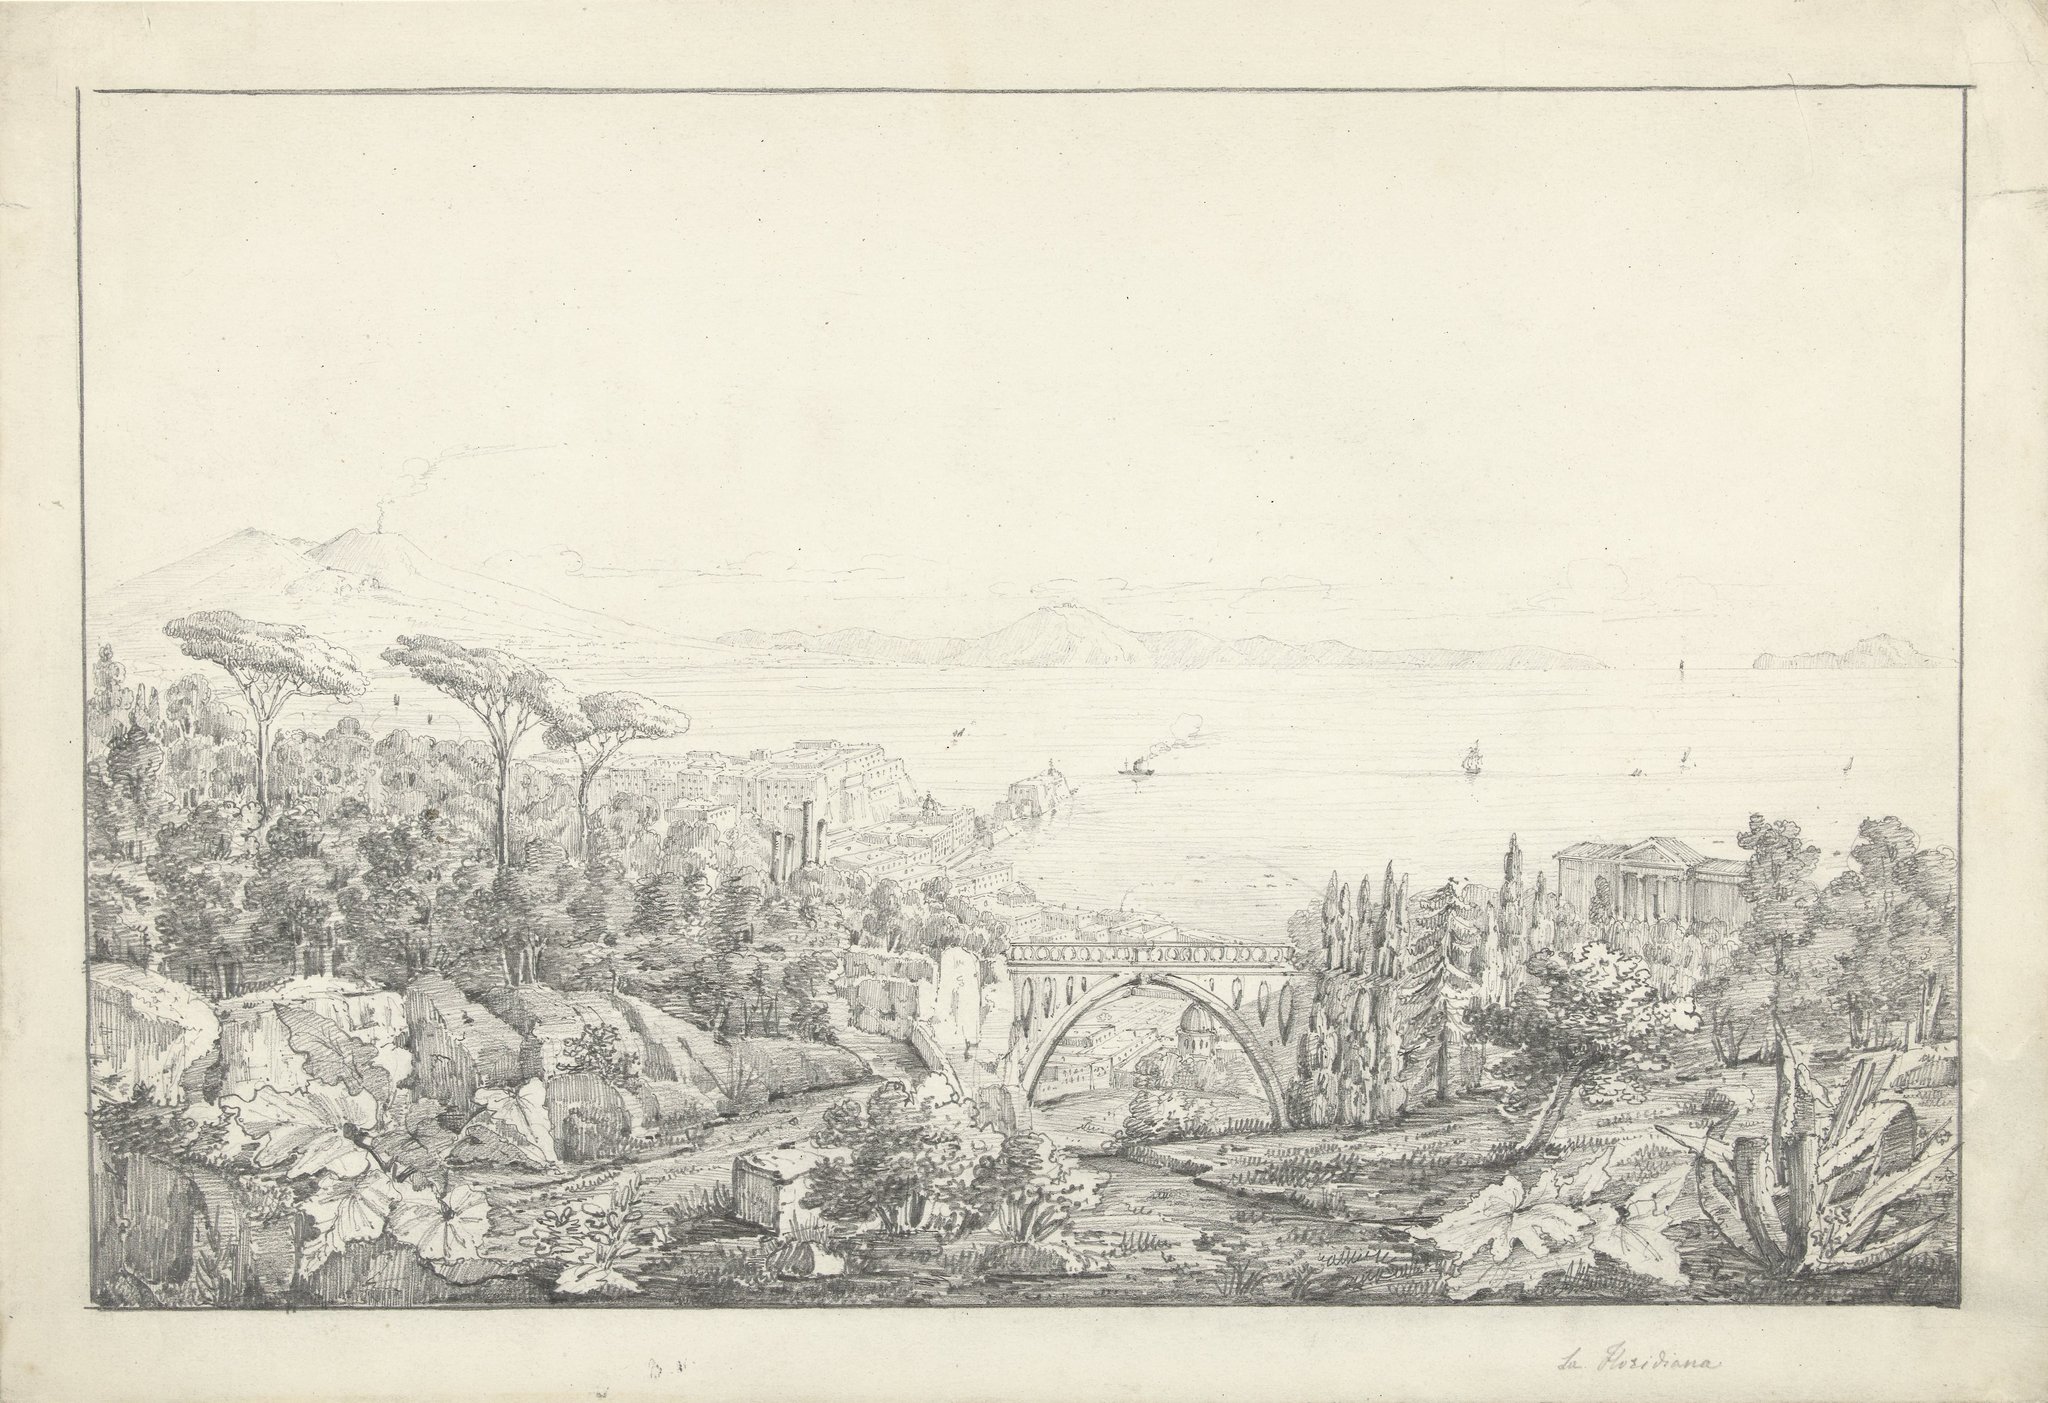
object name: drawing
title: Gezicht op de plantentuin bij Napels La Floridiana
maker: Anonymous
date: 1800-1900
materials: paper, pencil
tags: gulf, bay, garden, landscape with bridge, viaduct or aqueduct (+ city(-scape) with figures, staffage), city-view in general; 'veduta' (+ city(-scape) with figures, staffage), naples